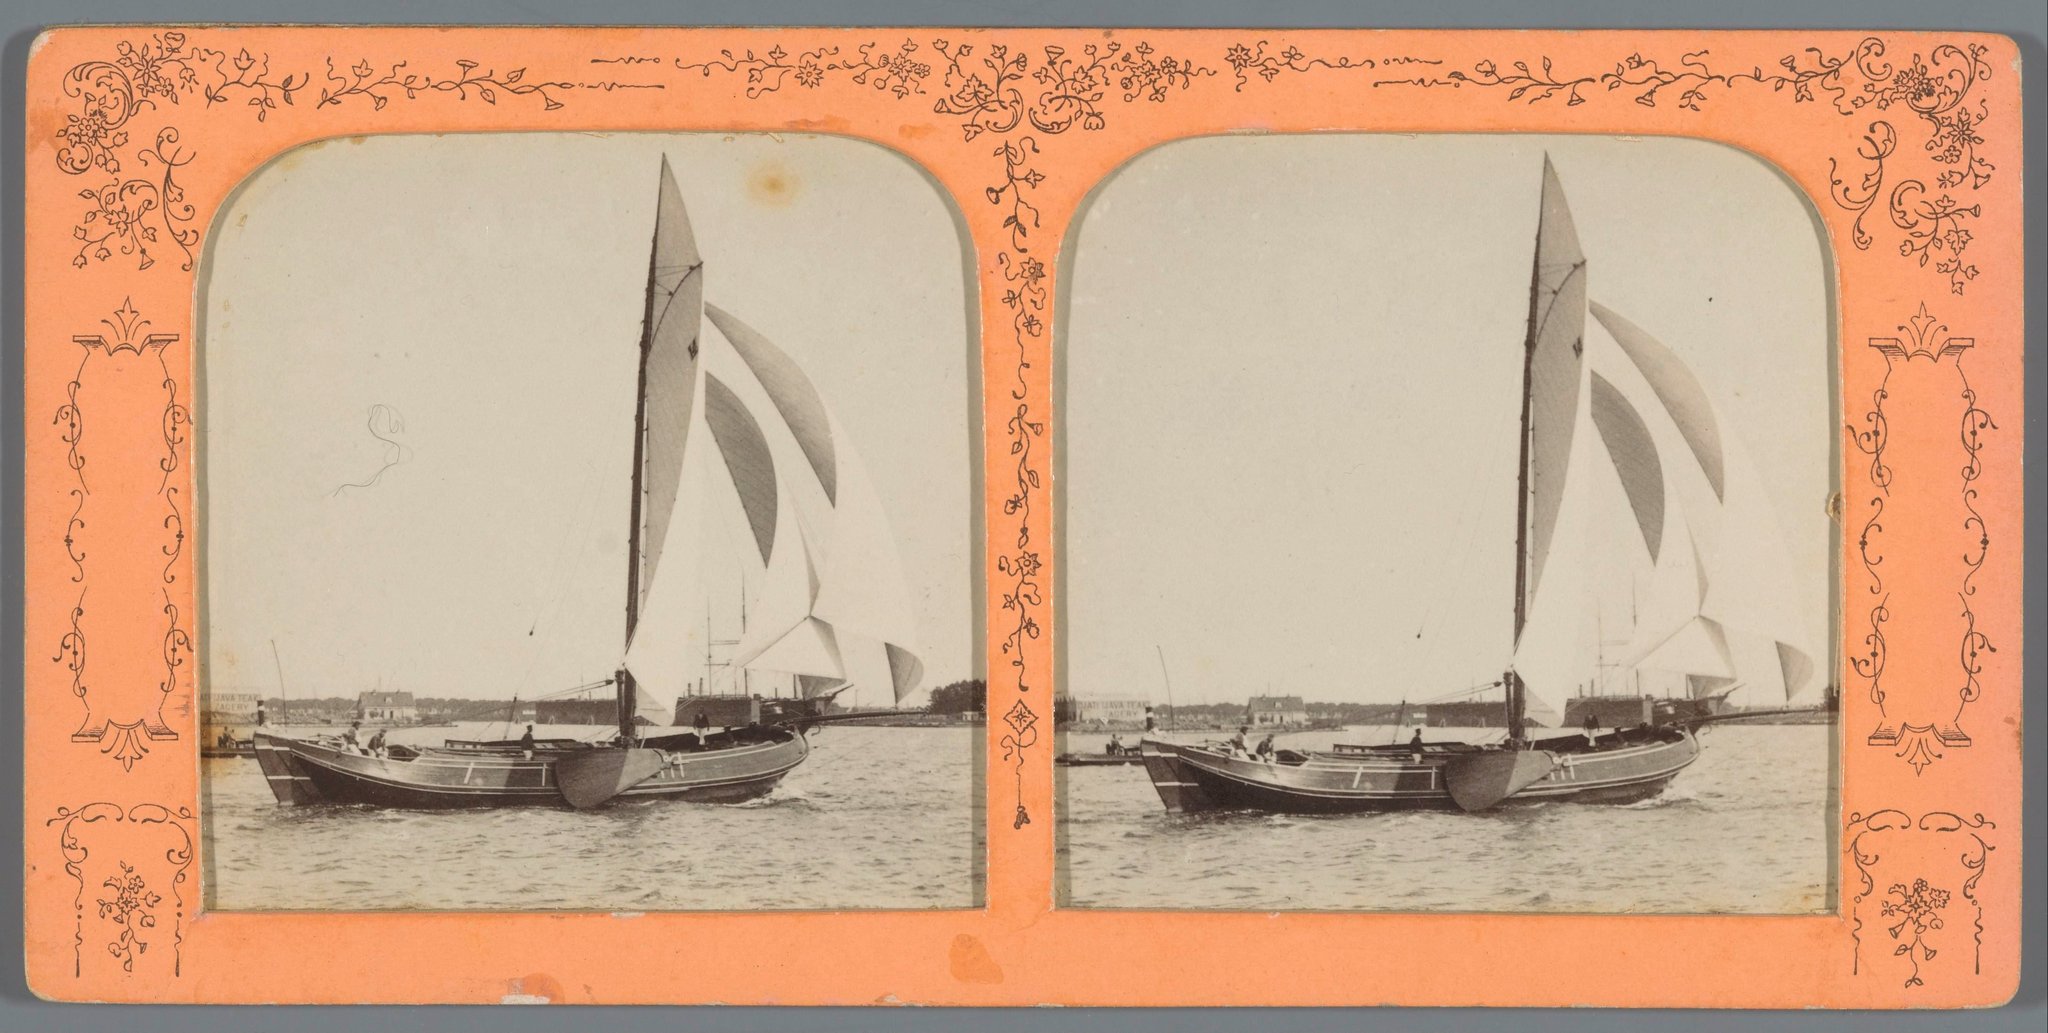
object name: tissue stereograph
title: Gezicht op een boot op het IJ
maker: Anonymous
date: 1855-1900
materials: cardboard, paper, photographic support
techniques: albumen print, hand coloring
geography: ij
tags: traffic on the water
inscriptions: inscription: ‘Op het IJ. Amsterdam’